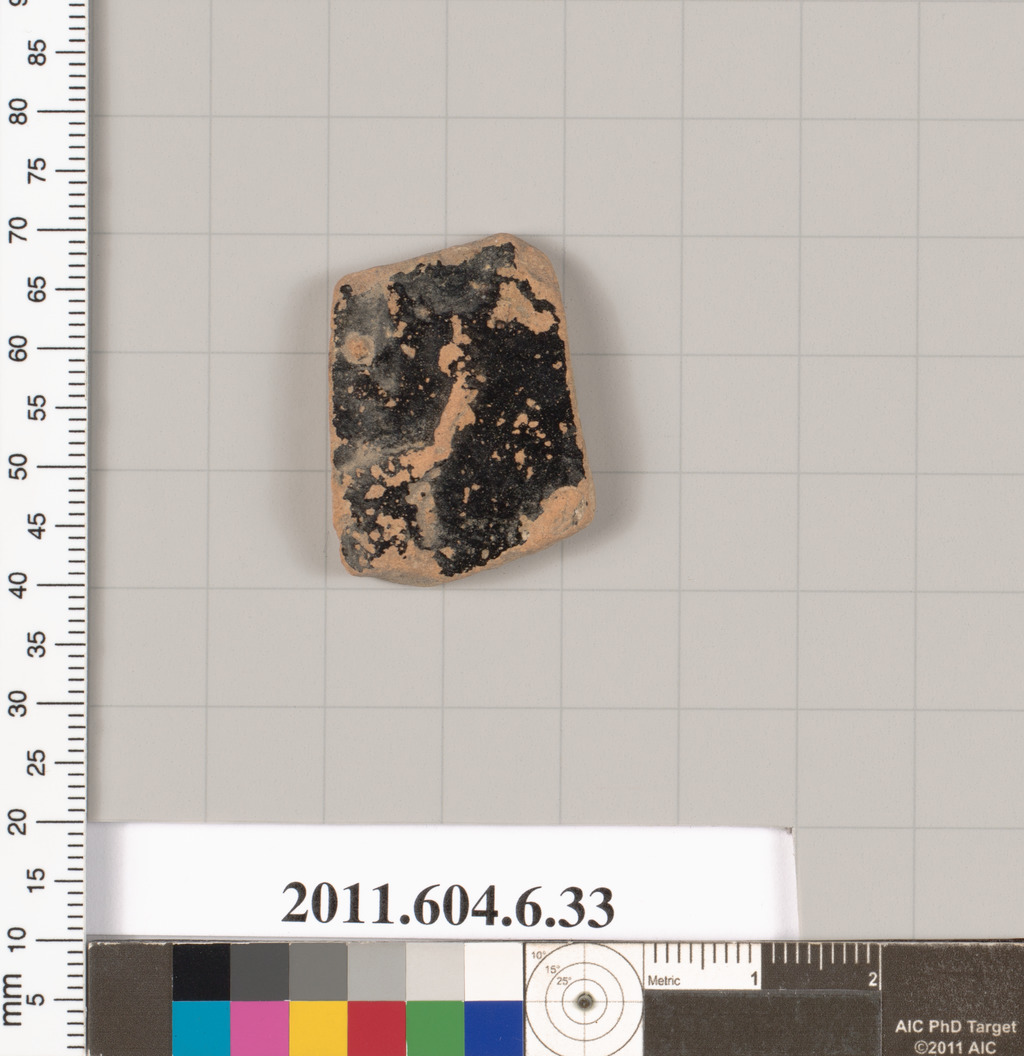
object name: undetermined open shape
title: Terracotta fragment of an open shape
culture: greek, attic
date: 375-325 BCE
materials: terracotta